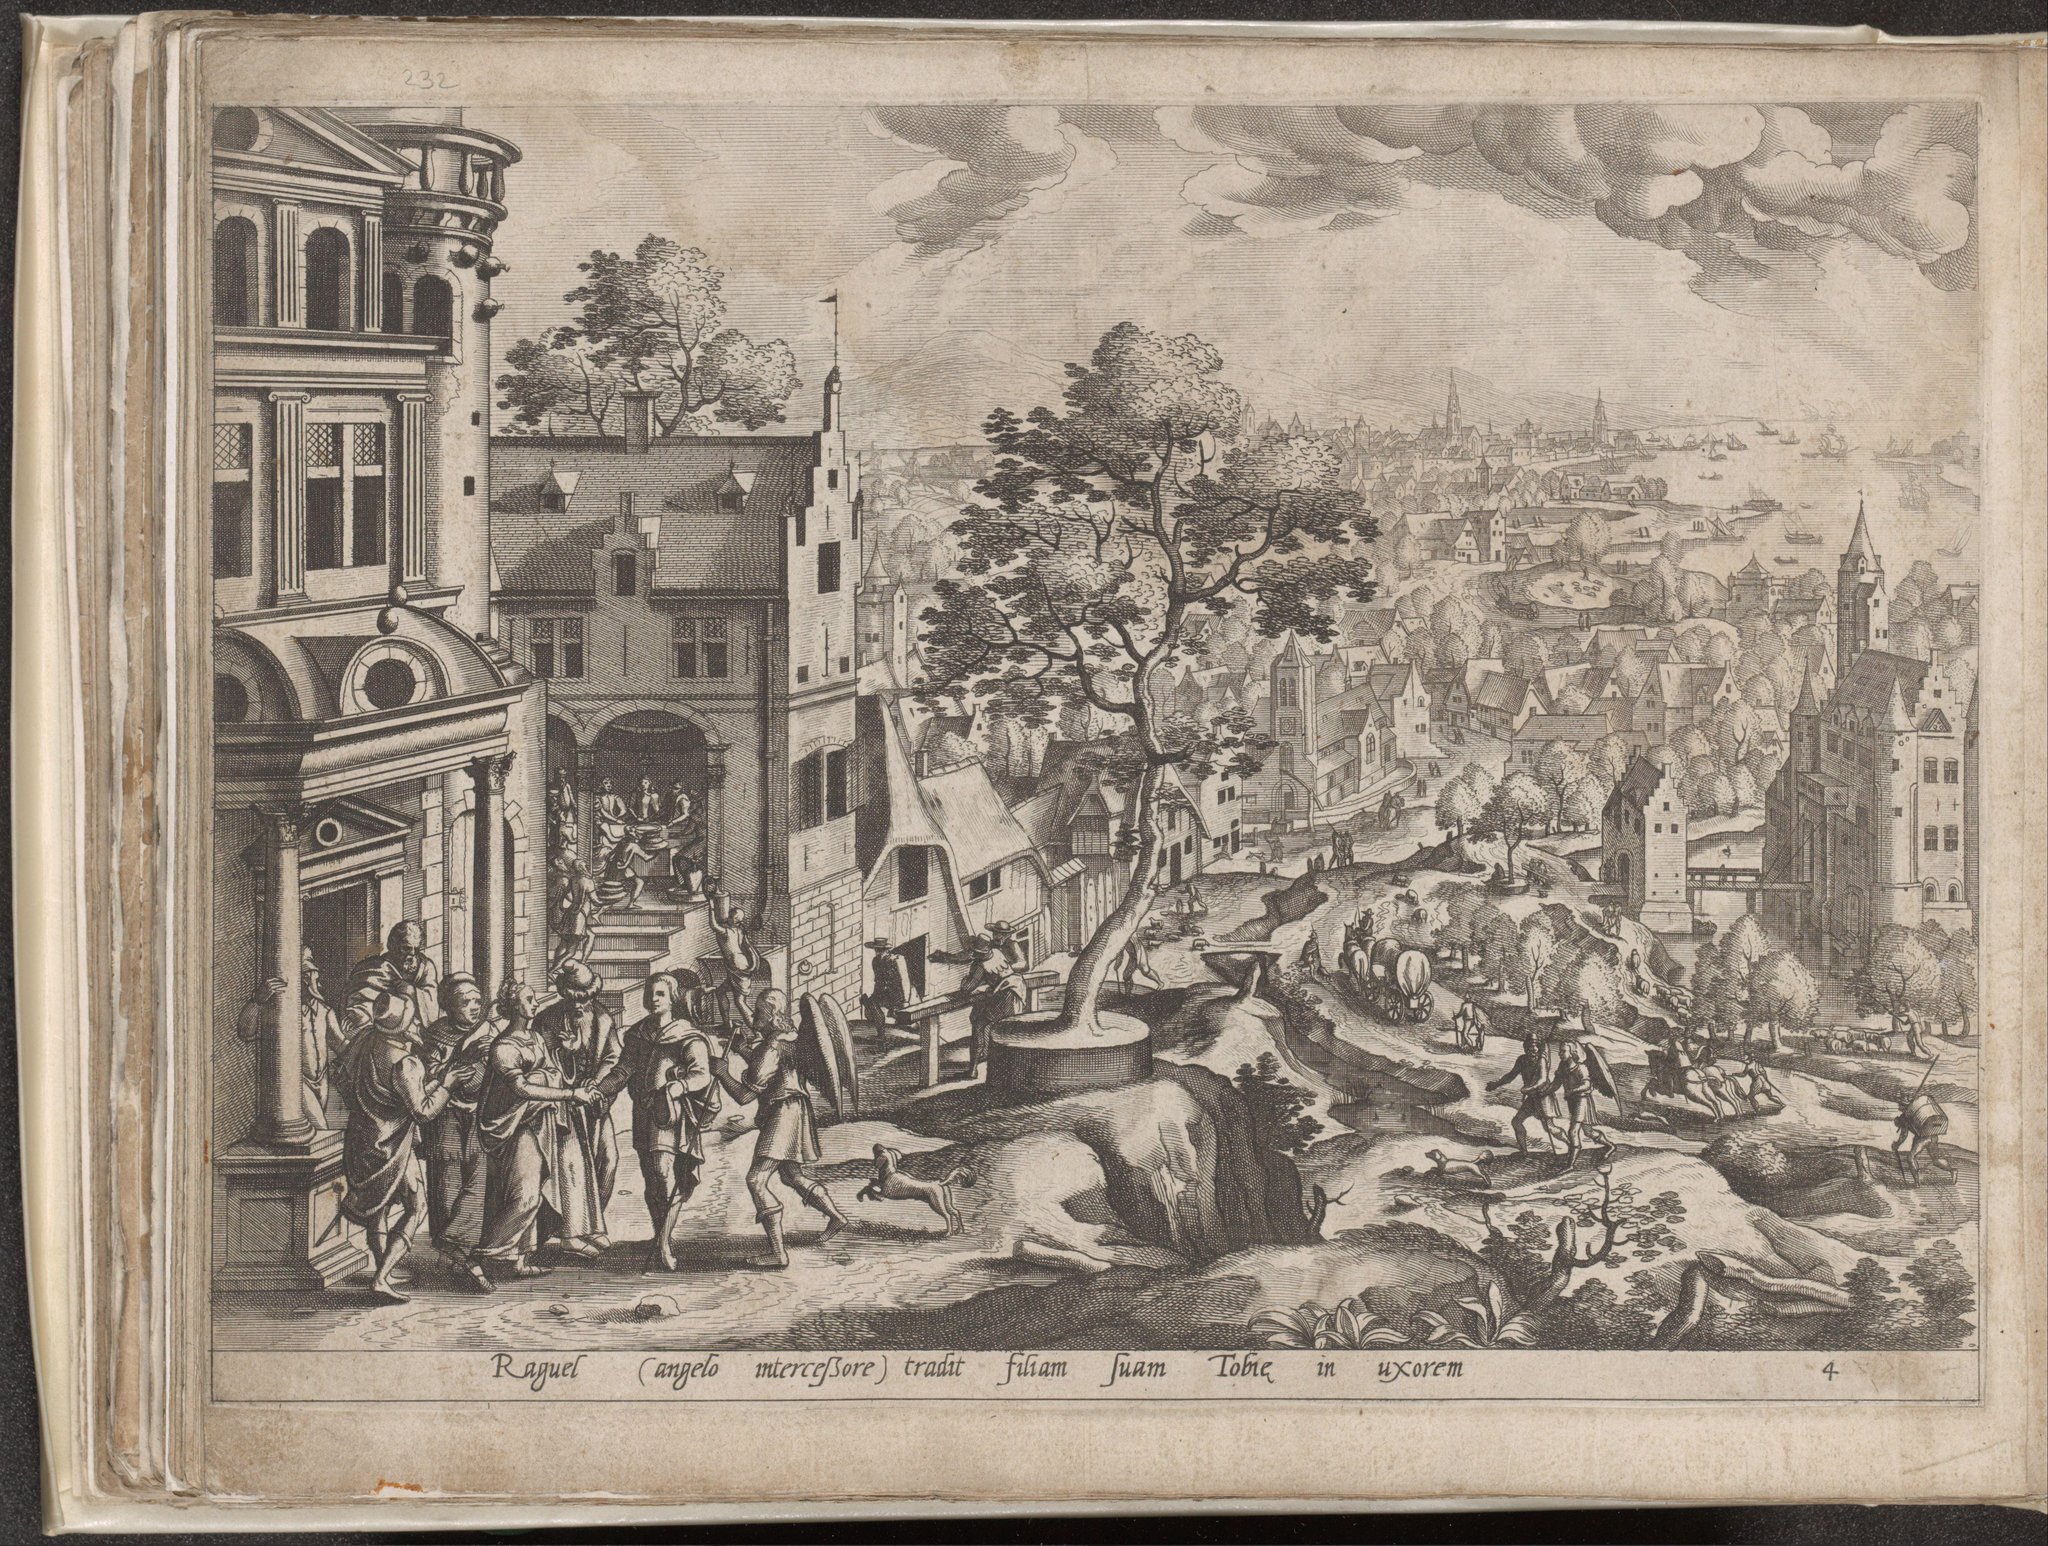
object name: album leaf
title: Tobias trouwt met Sara, de dochter van Raguel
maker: johannes of lucas van doetechum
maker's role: print maker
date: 1563-1567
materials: paper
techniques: engraving, etching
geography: antwerp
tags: river, the marriage feast of tobias and sarah, raguel gives sarah to tobias as his wife, village, tobias and the angel raphael continue their journey; usually tobias carrying the fish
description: Landschap met in het midden Tobias en de engel vergezeld door Tobias' hond op weg naar het huis van Raguel. Voor het huis van Raguel rechts worden Tobias en Sara door Raguel in de echt verbonden. De engel staat naast Tobias. Op de achtergrond in het huis het bruiloftsmaal. Op de achtergond een stad en een kasteel in een landschap. Onder de voorstelling een verklarende tekst in het Latijn. Deze prent maakt deel uit van een album.